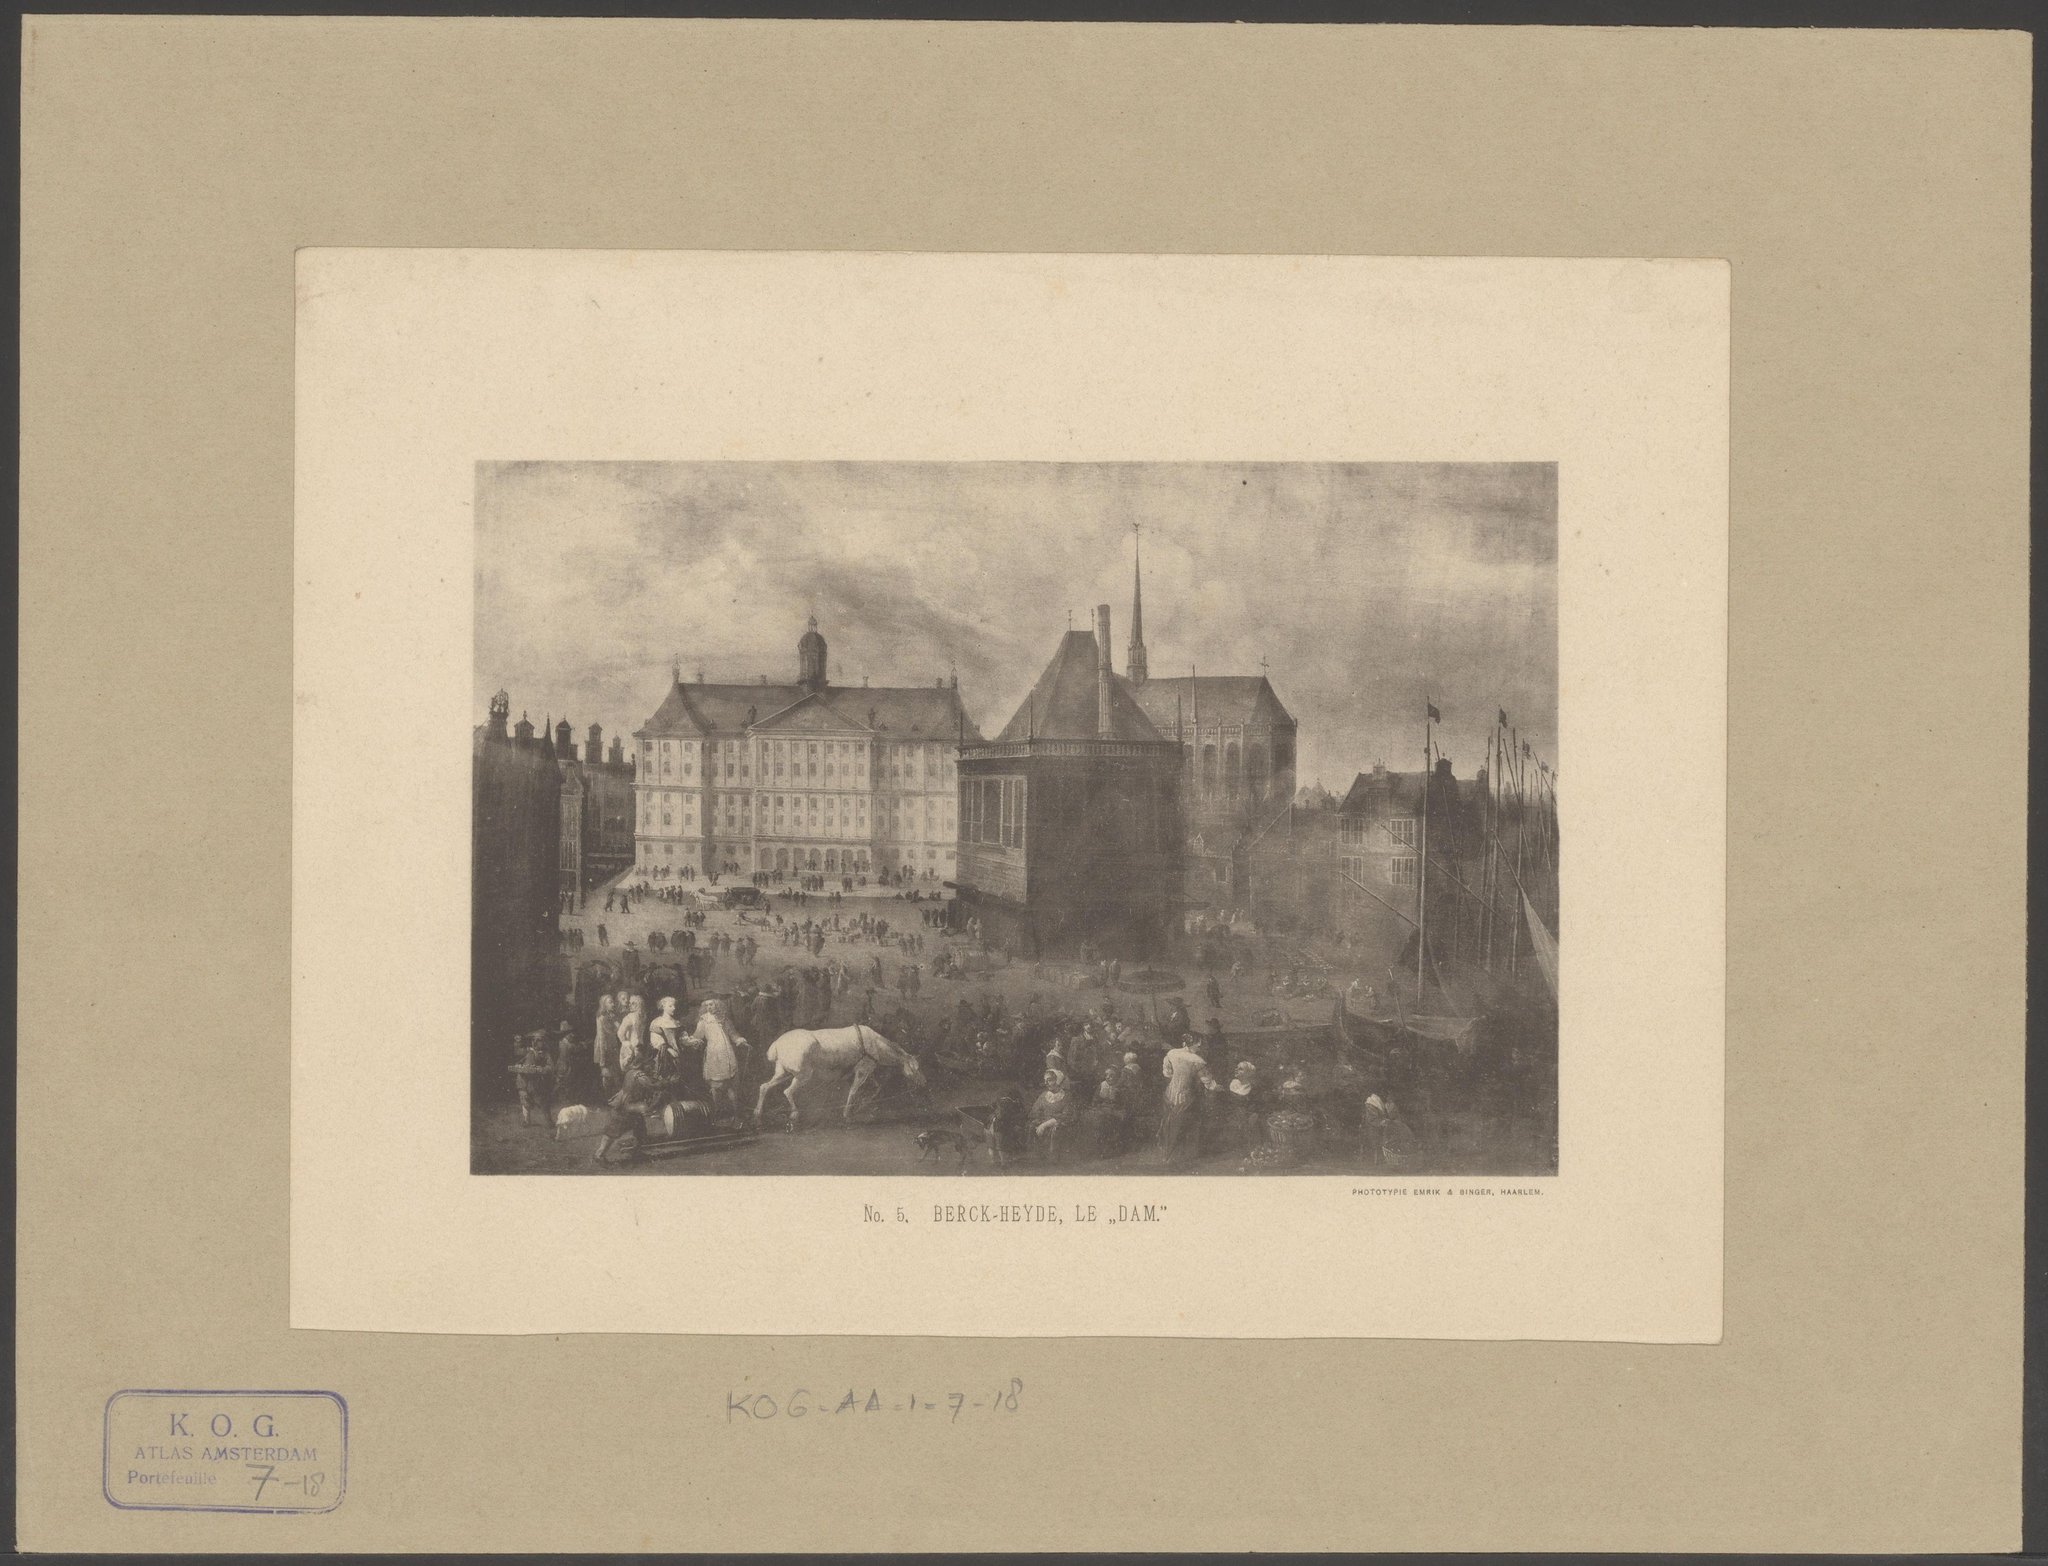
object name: photomechanical print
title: Gezicht op het Stadhuis, de Nieuwe Kerk en de Waag op de Dam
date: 1898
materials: paper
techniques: photograph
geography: haarlem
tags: square, place, circus, etc., city-view in general; 'veduta', church (exterior), townhall, weigh-house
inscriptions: inscription: ‘Verk. A[..] 1 Maart 1898.’, collector's mark: ‘7’ Lugt 1641b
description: Onderwerpsrubriek binnen de Atlas Amsterdam: Dam (voor 1835).